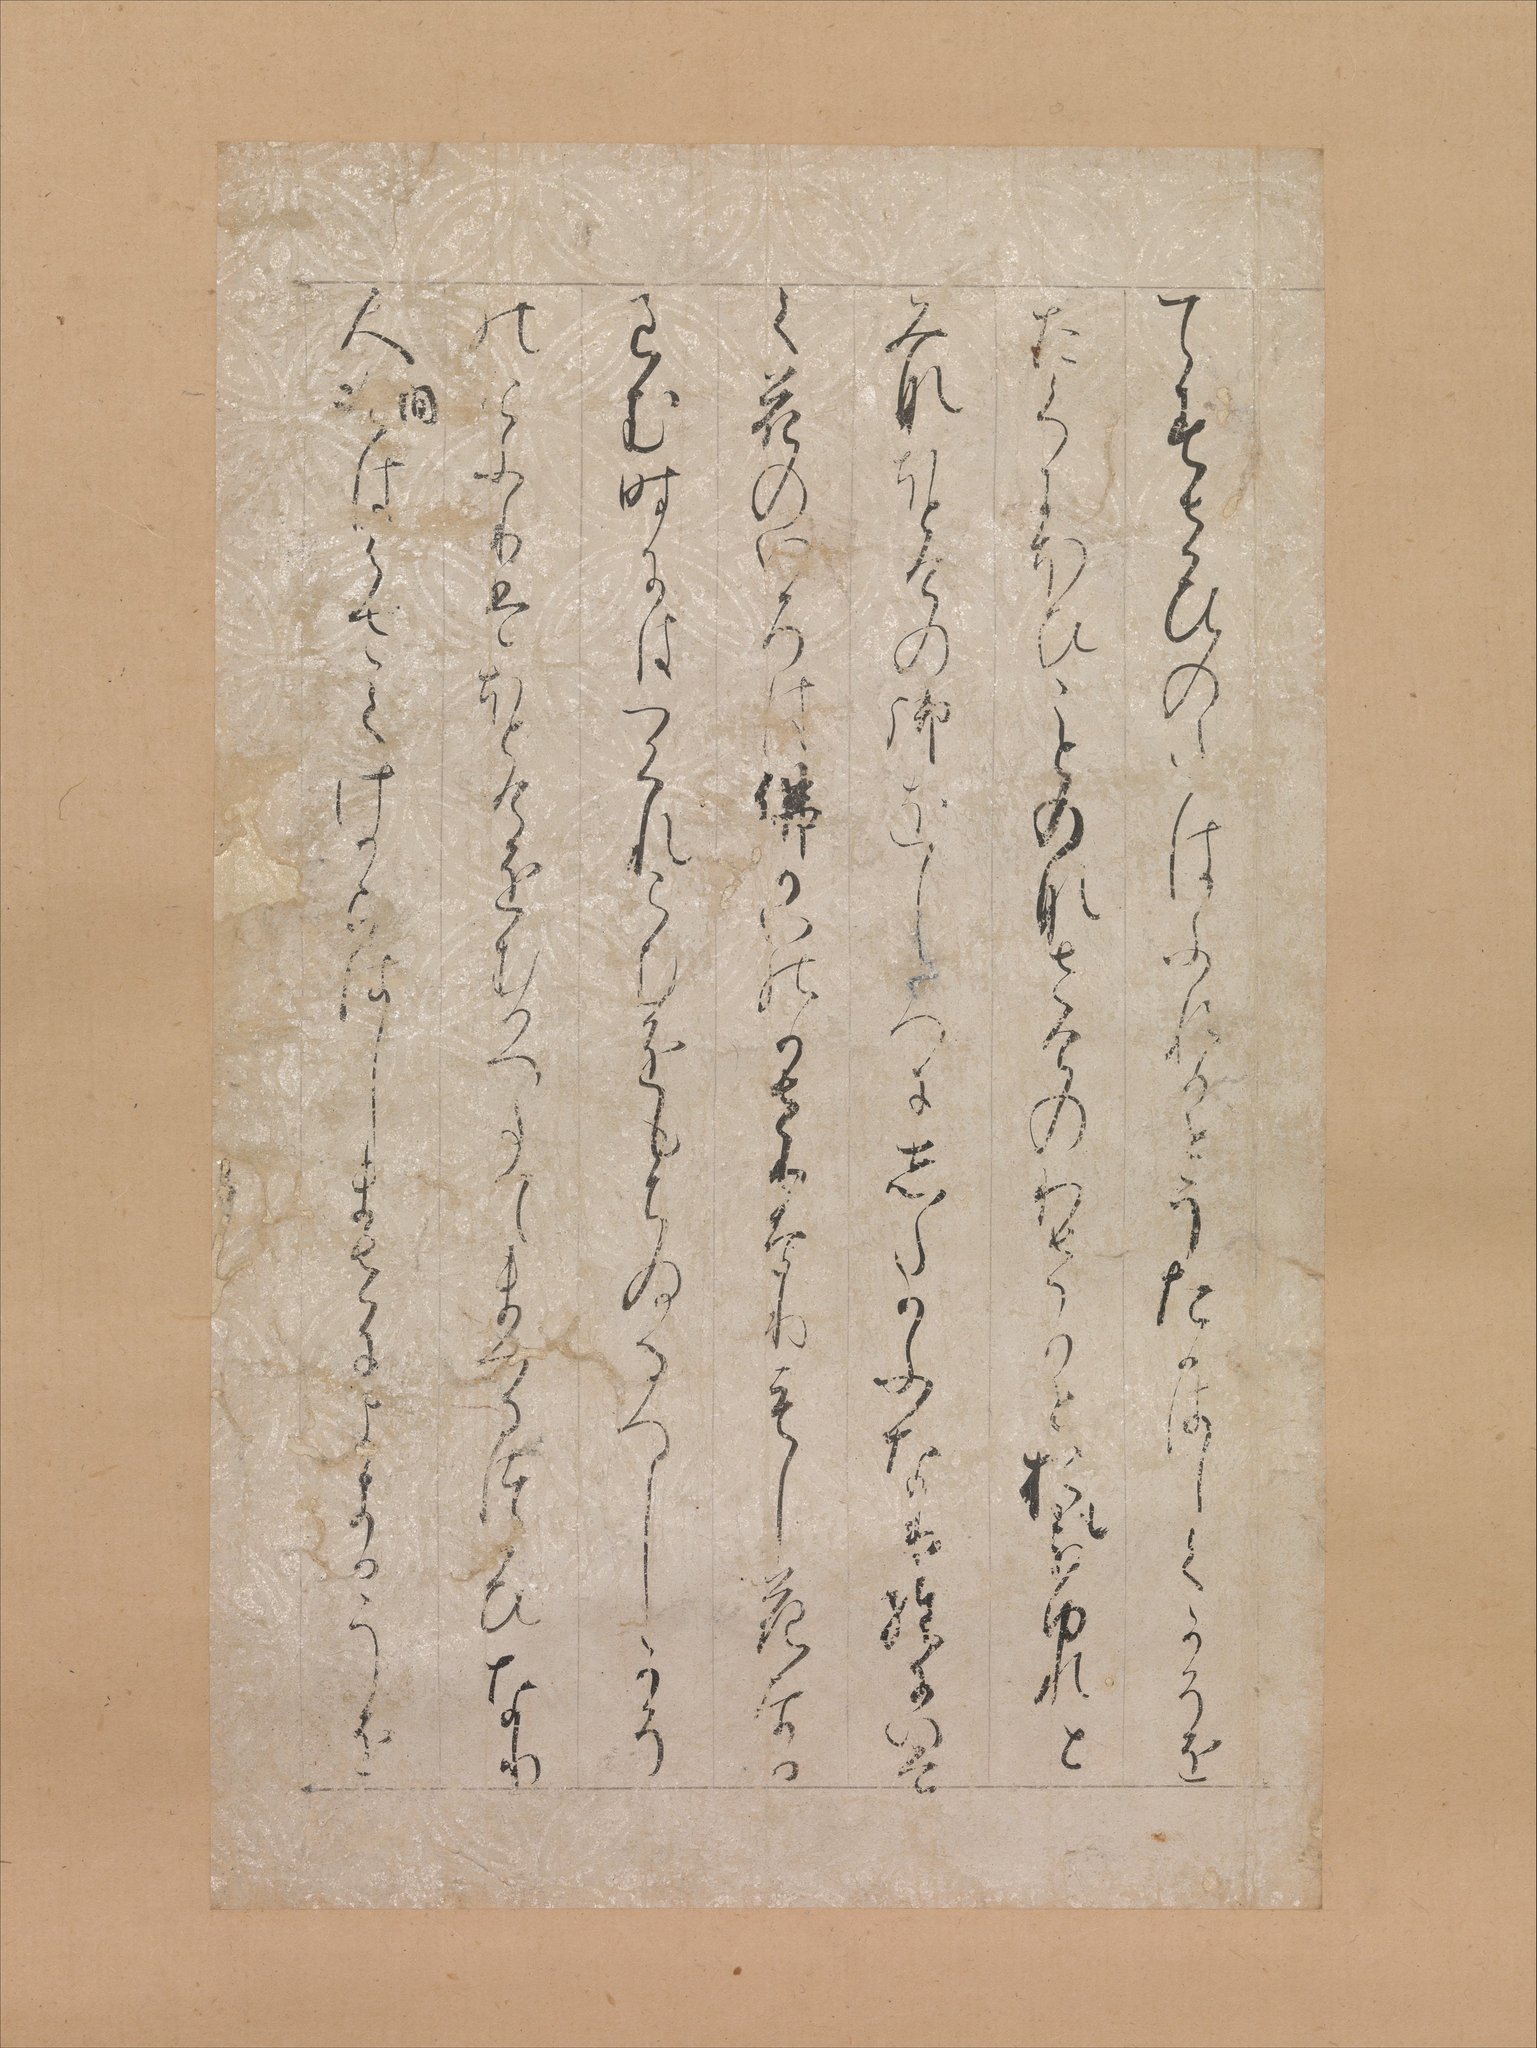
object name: hanging scroll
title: Page from the Illustrations and Explanations of the Three Jewels (Sanbō ekotoba), known as the Tōdaiji Fragment (Tōdaiji-gire)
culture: japanese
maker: minamoto no toshiyori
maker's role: artist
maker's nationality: japanese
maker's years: 1055-1129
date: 1120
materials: ink, mica, paper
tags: calligraphy